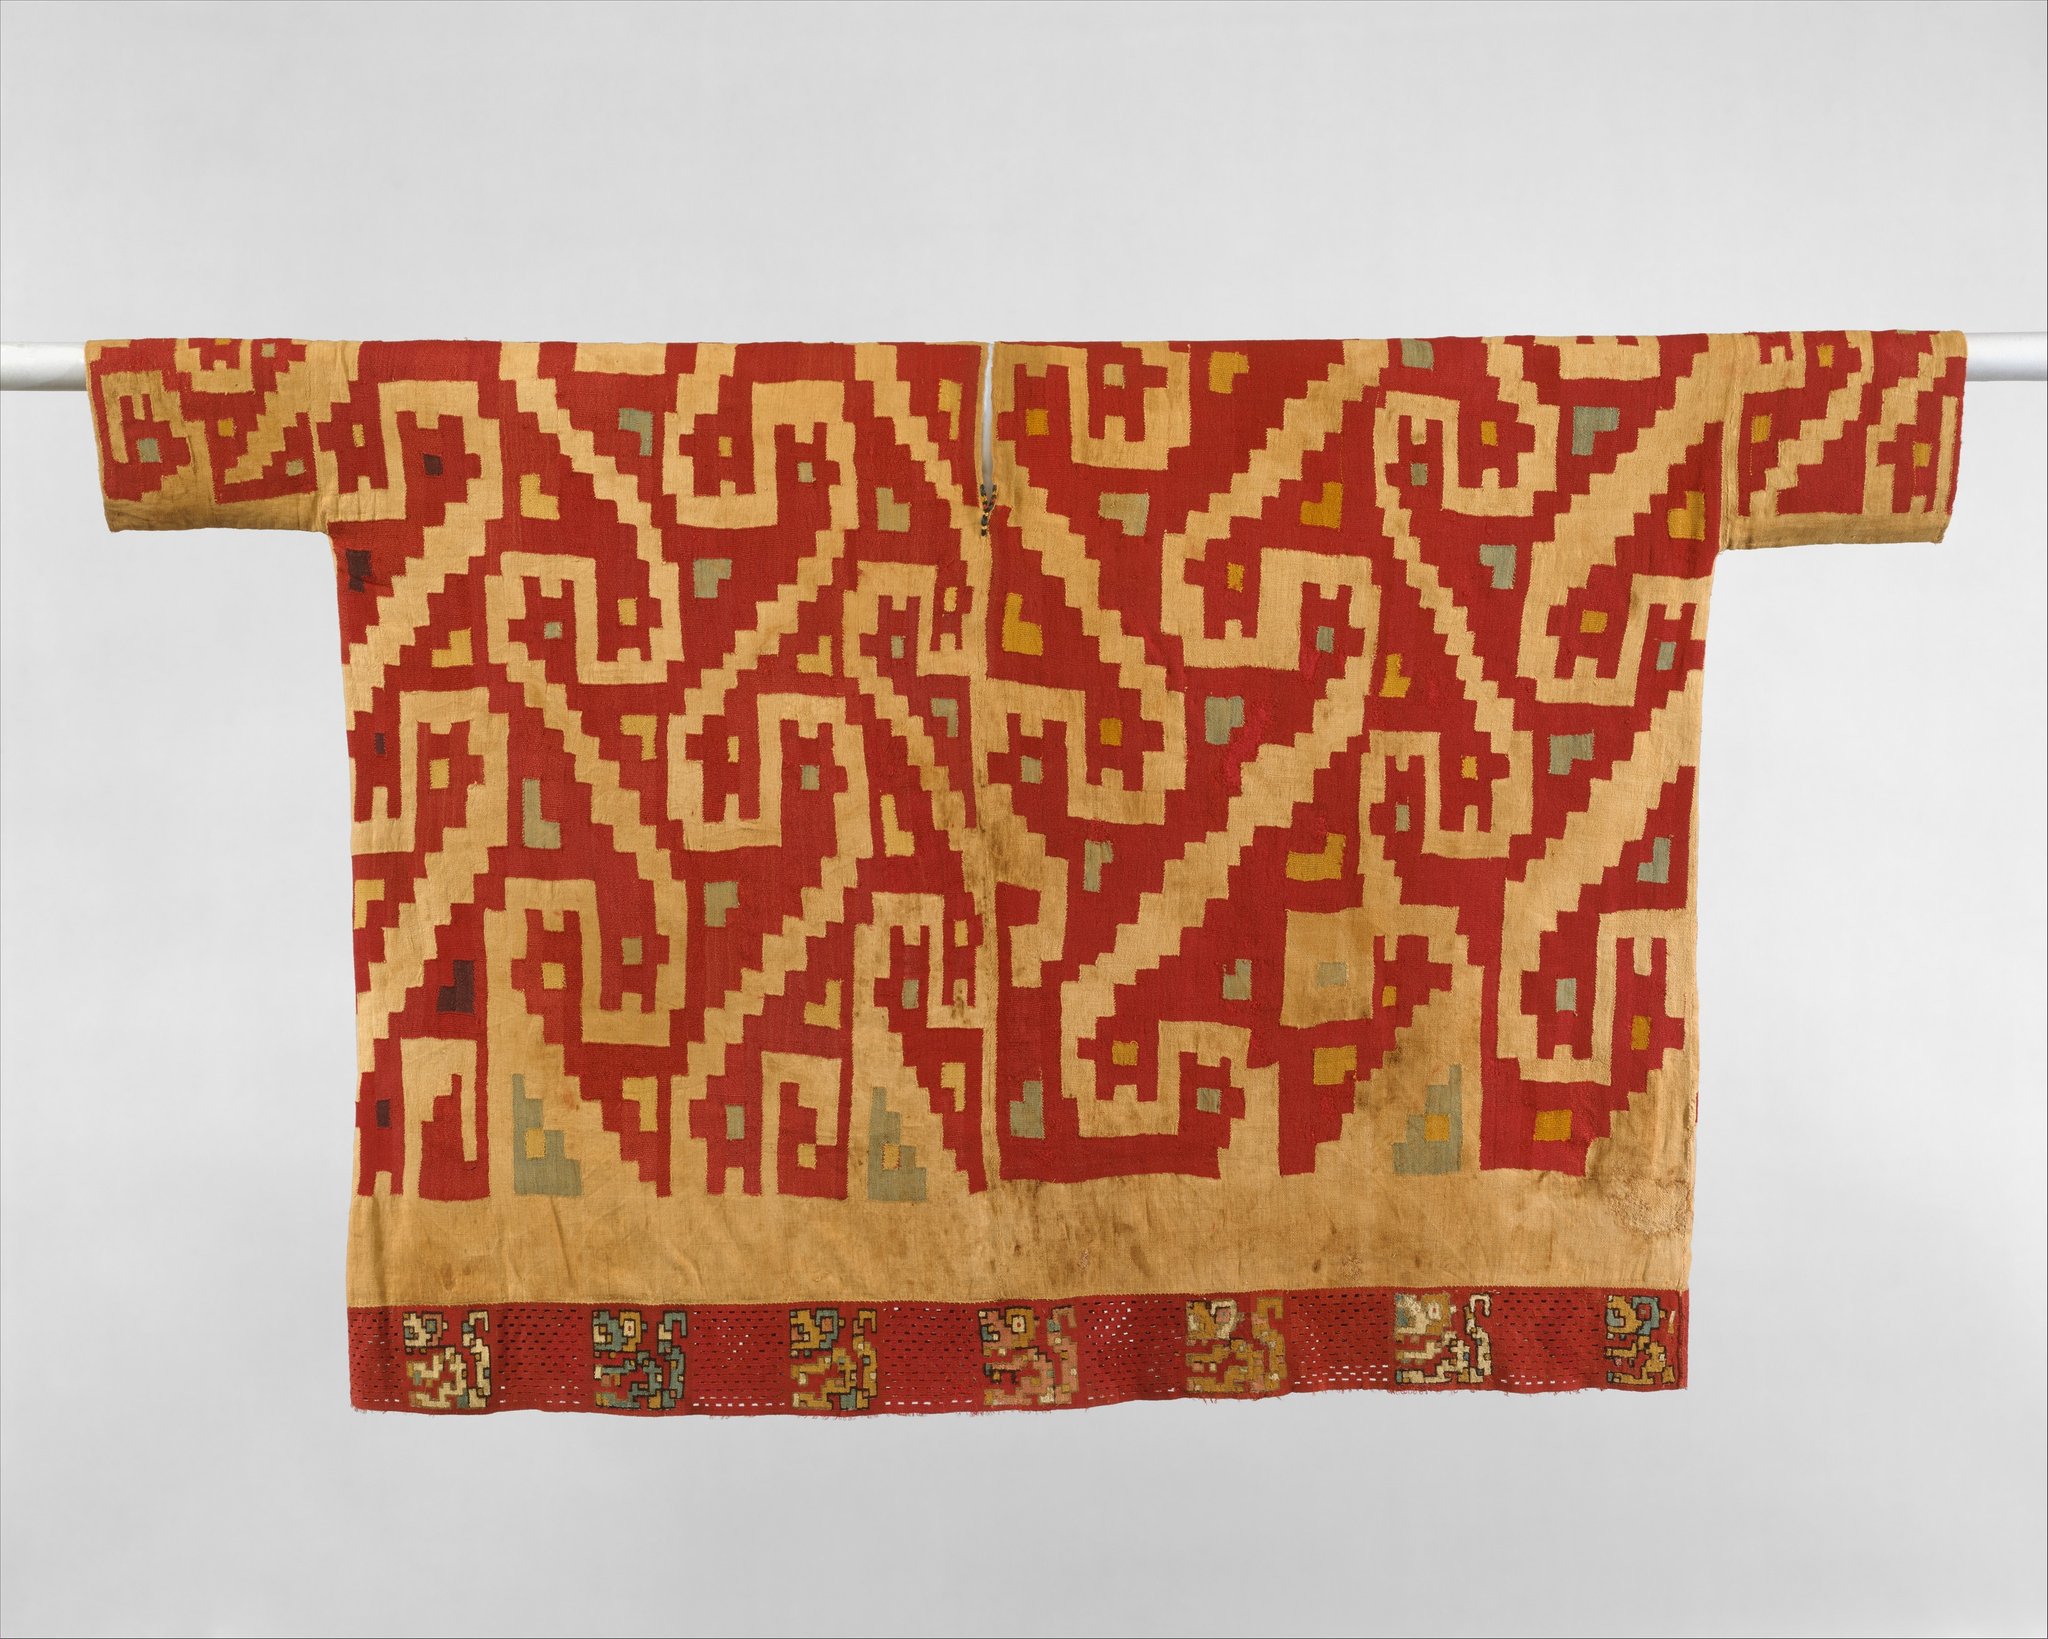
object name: shirt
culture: moche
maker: moche artist(s)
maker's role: artist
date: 500-850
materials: animal fiber, cotton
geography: peru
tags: animals